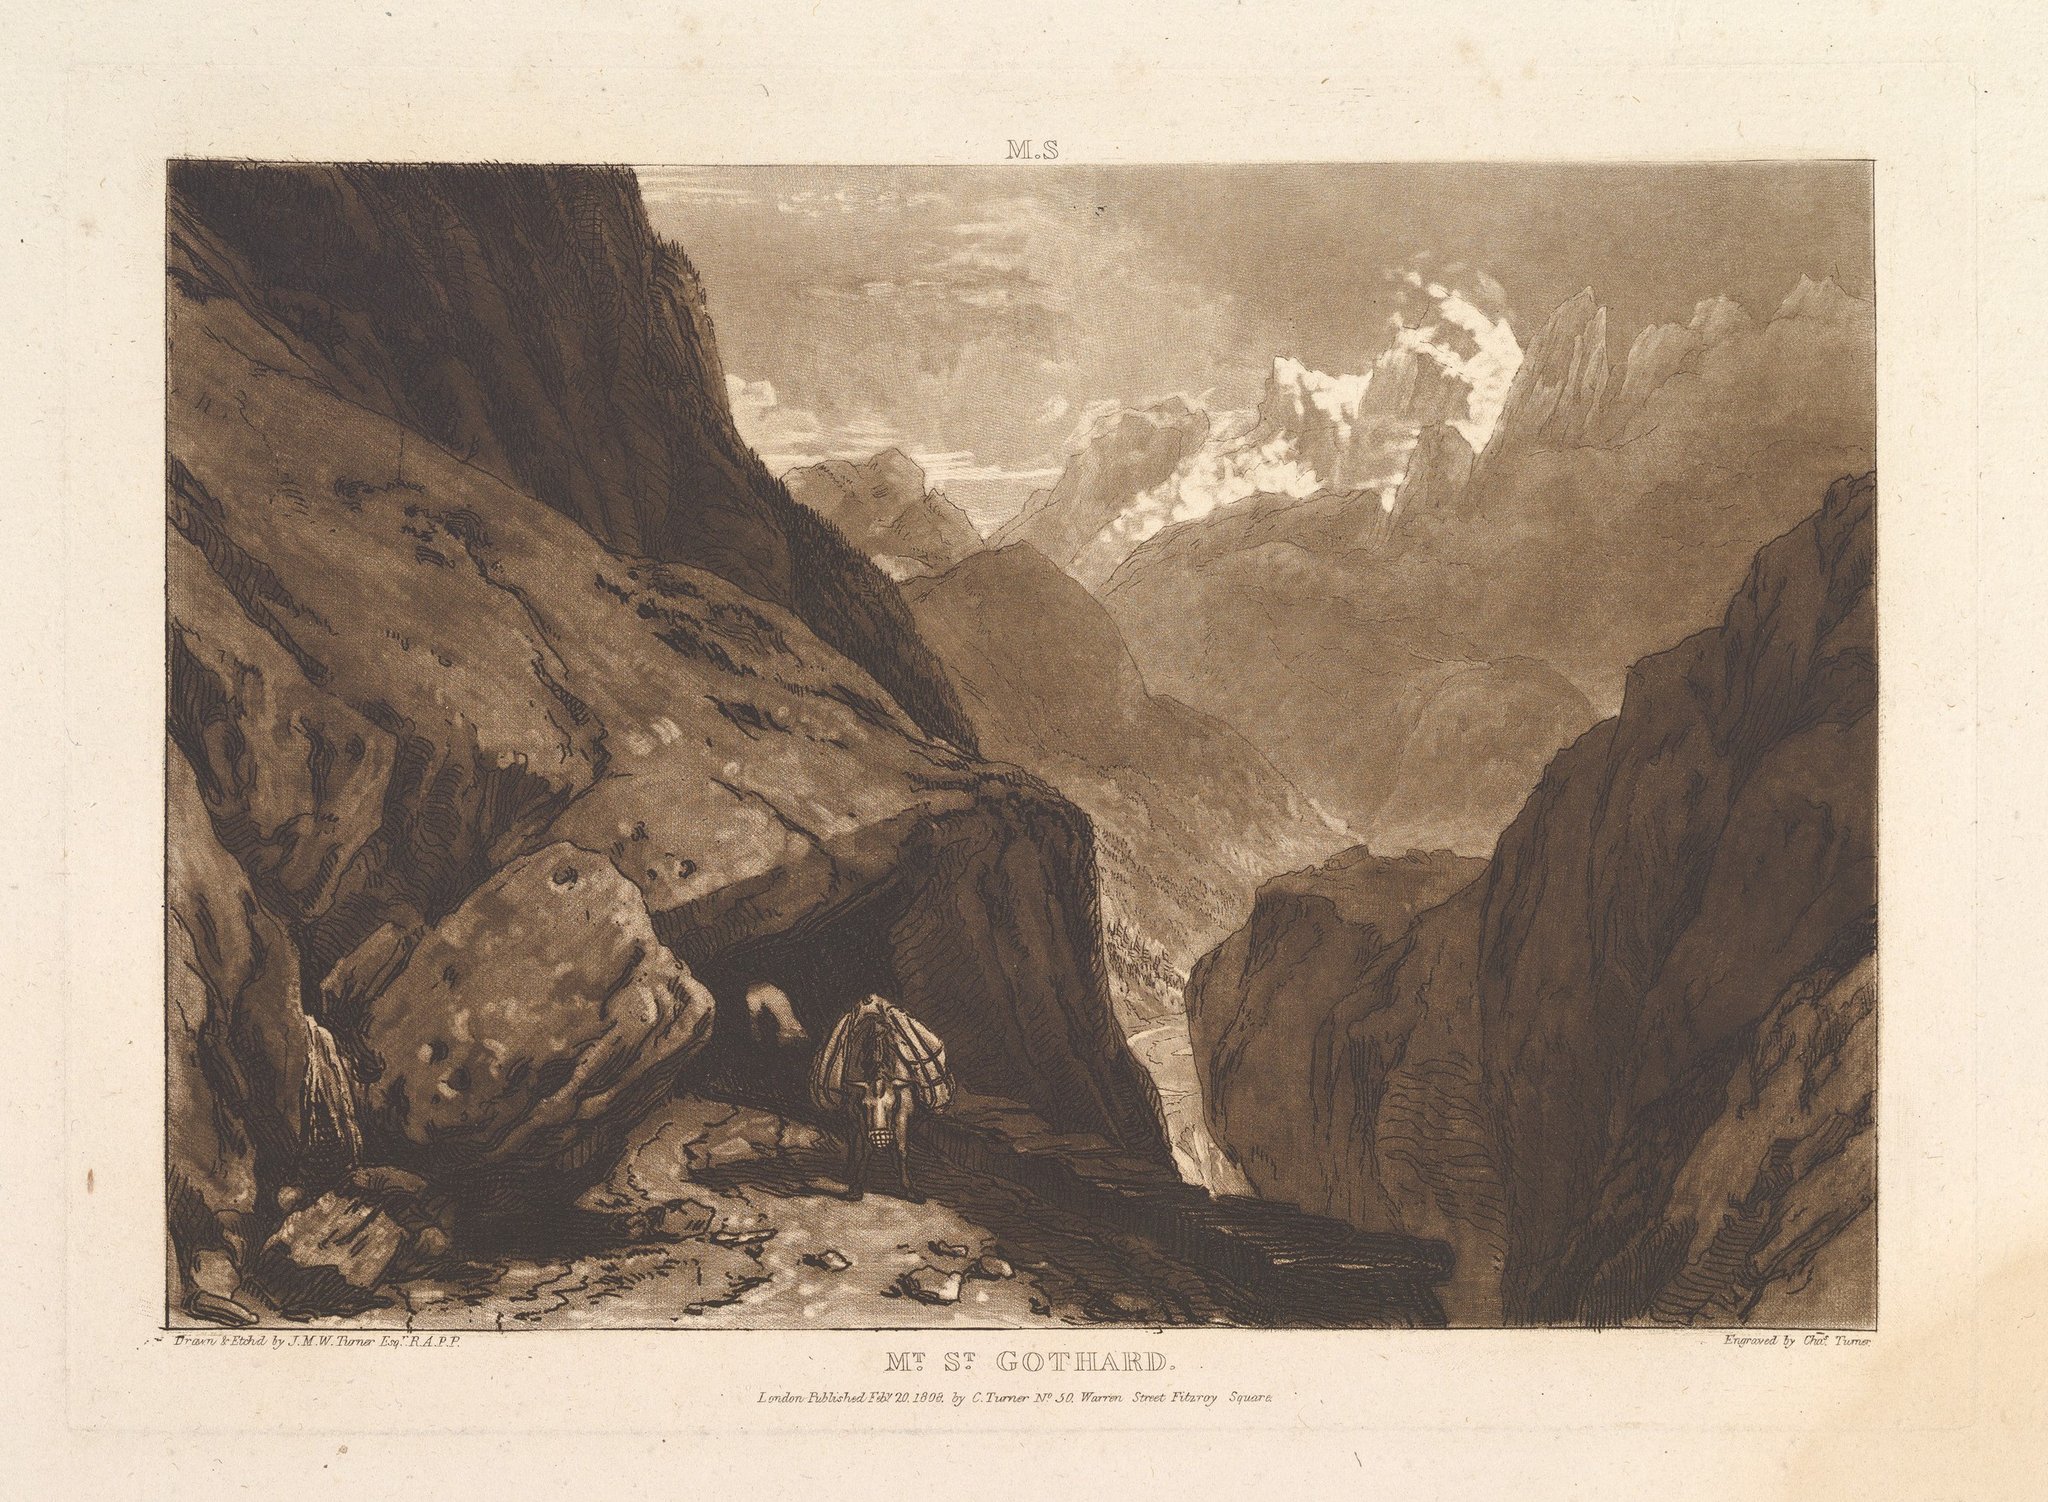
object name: print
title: Mt. St. Gothard, part II, plate 9 from "Liber Studiorum"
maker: joseph mallord william turner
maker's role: artist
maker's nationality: british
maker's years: 1775-1851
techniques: etching, mezzotint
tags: mountains,landscapes